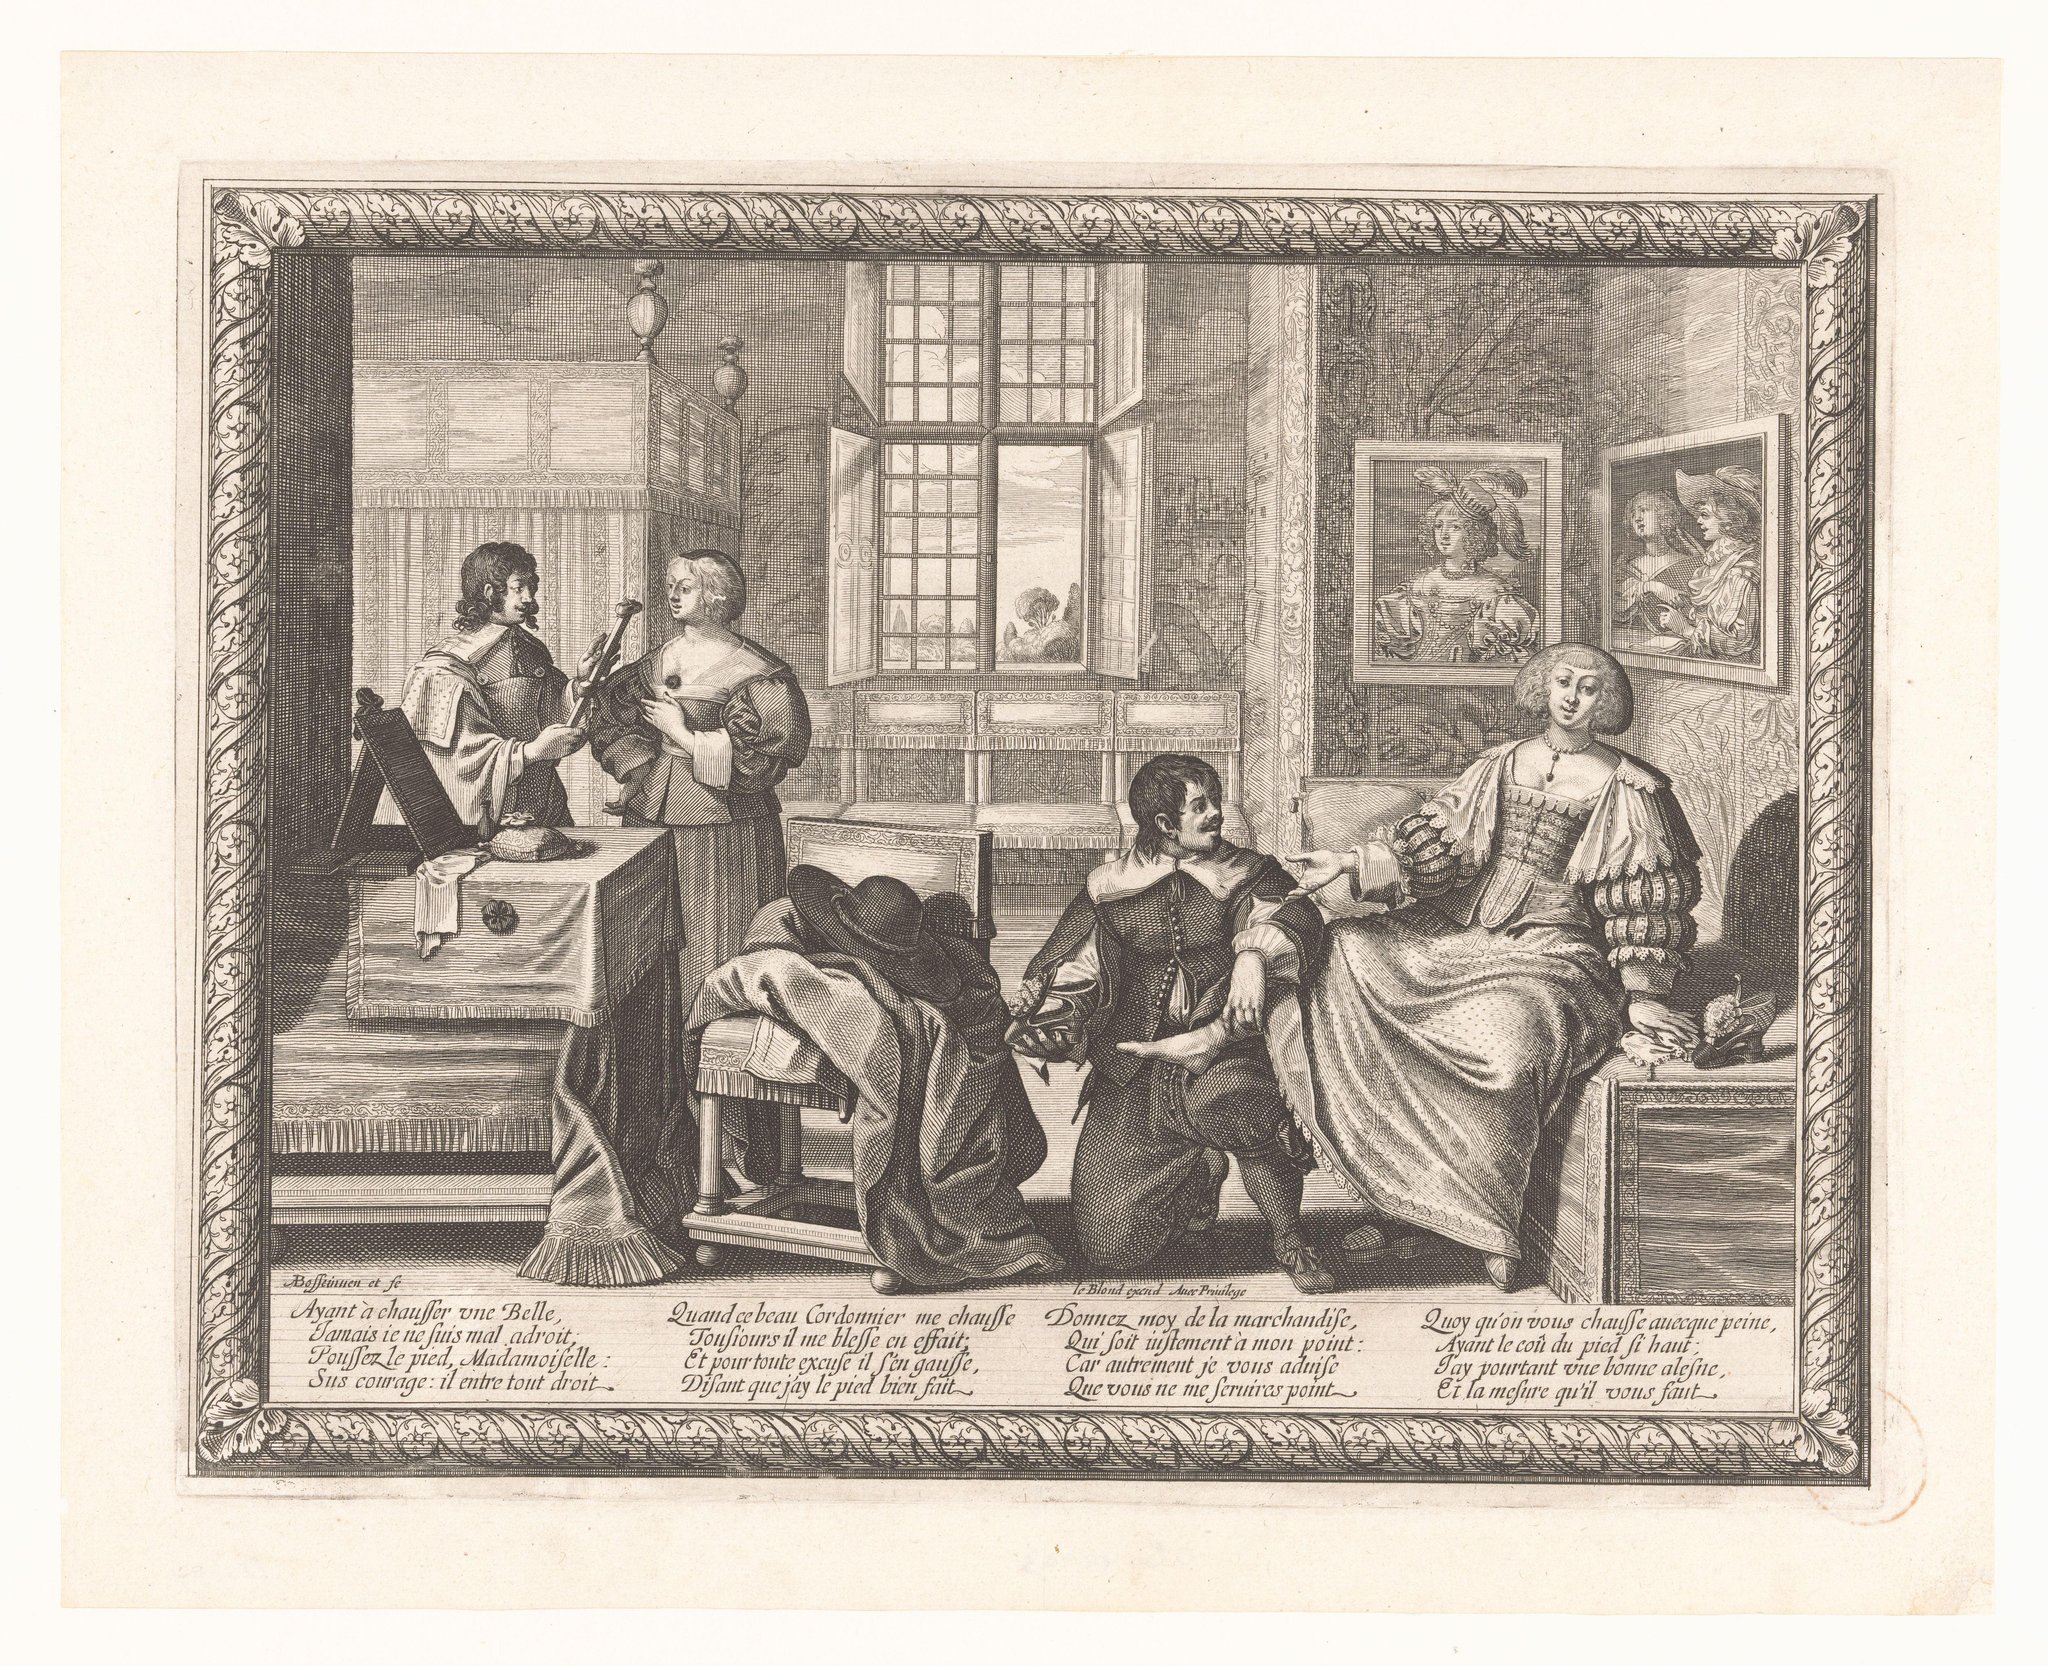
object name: print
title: Les Métiers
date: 1632-1633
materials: paper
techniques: etching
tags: bed with tester, mirror, putting on (tying) or taking off (untying) sandals or shoes - aa - female human figure, head-gear: hat (+ men's clothes), clothes, costume (+ women's clothes), shoes, sandals (+ women's clothes), dress, gown (+ women's clothes), clothes, costume (+ men's clothes), picture, painting, tapestry, neck-gear: collar (+ men's clothes), sleeves (+ women's clothes), bedroom, shoe-maker, cobbler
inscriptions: collector's mark: Lugt 240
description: In een slaapvertrek met links een hemelbed en gobelins en schilderijen aan de wand zit een dame, gekleed volgens de Franse mode rond 1630. Voor haar zit een schoenmaker op zijn knieën. Hij heeft zijn mantel en hoed op een stoel gelegd en past een schoen met rozet aan de voet van de vrouw. Naast haar op de kist staat de tweede schoen. De schoenen zijn karakteristiek voor de periode rond 1630. De hak werd beschermd door een 'patin', die men eroverheen droeg als men naar buiten ging en die men binnenshuis verwijderde. De schoen had grotendeels open zijkanten die bovenop de wreef bijeengehouden werden door twee lange riempjes waarvan de aanhechting werd gemaskeerd door een grote bloem van stof (rozet).